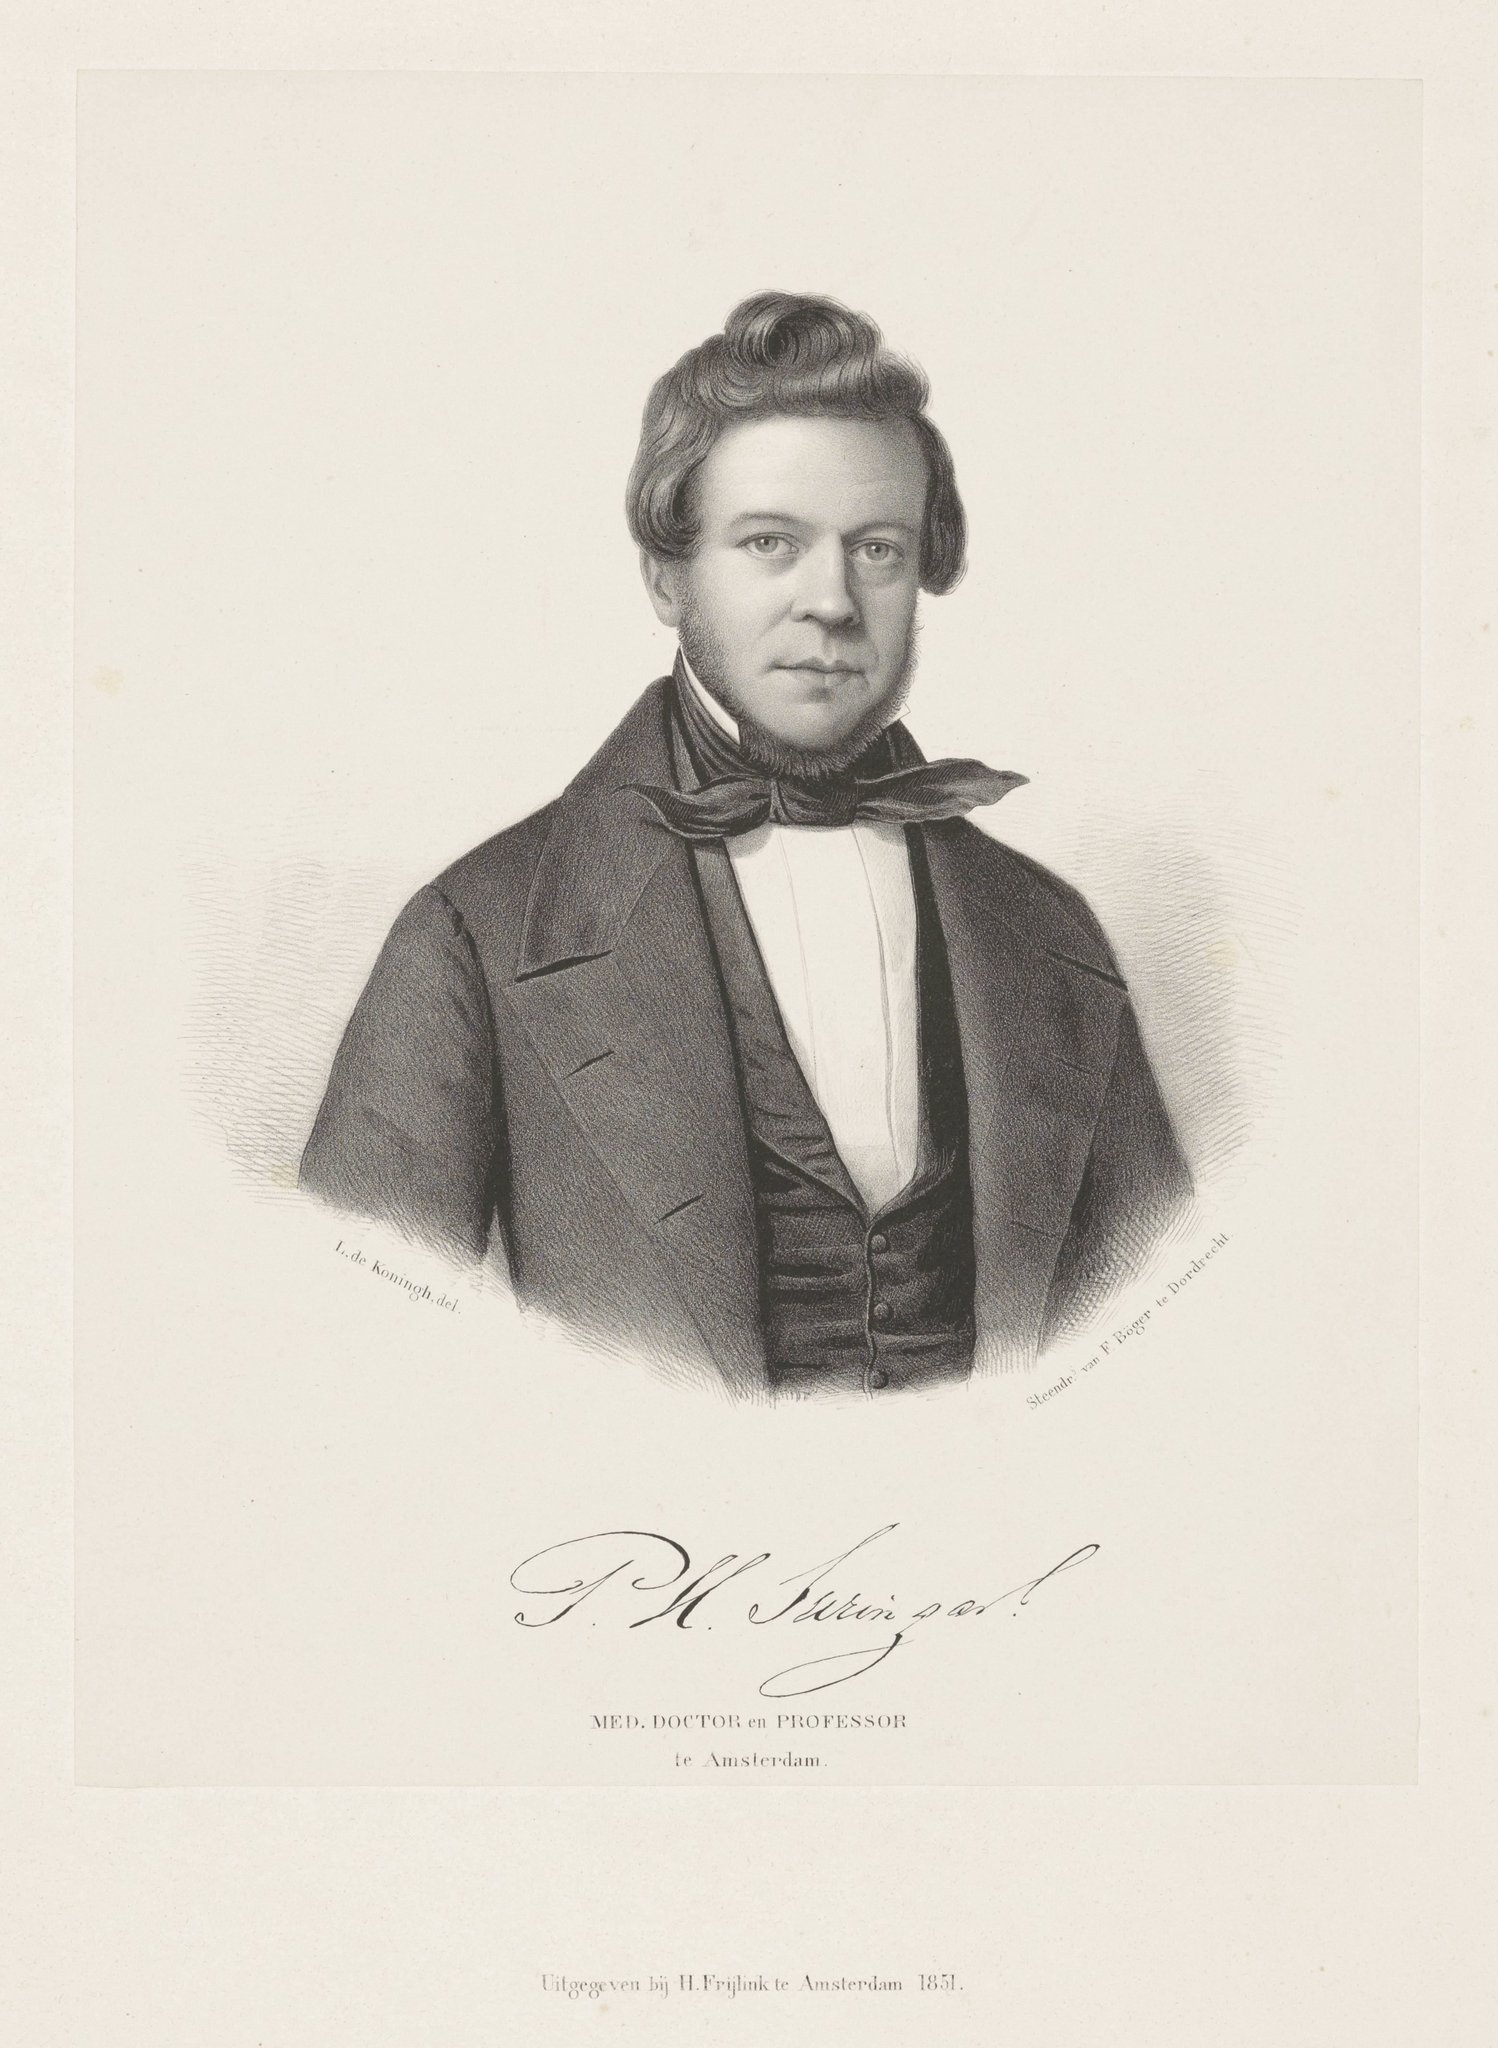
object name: print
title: Portret van Pieter Hendrik Suringar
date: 1851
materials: paper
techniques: lithograph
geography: dordrecht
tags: amsterdam, historical persons (+ (full) bust portrait)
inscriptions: collector's mark: Lugt 2228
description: Onder het portret zijn signatuur en beroep.